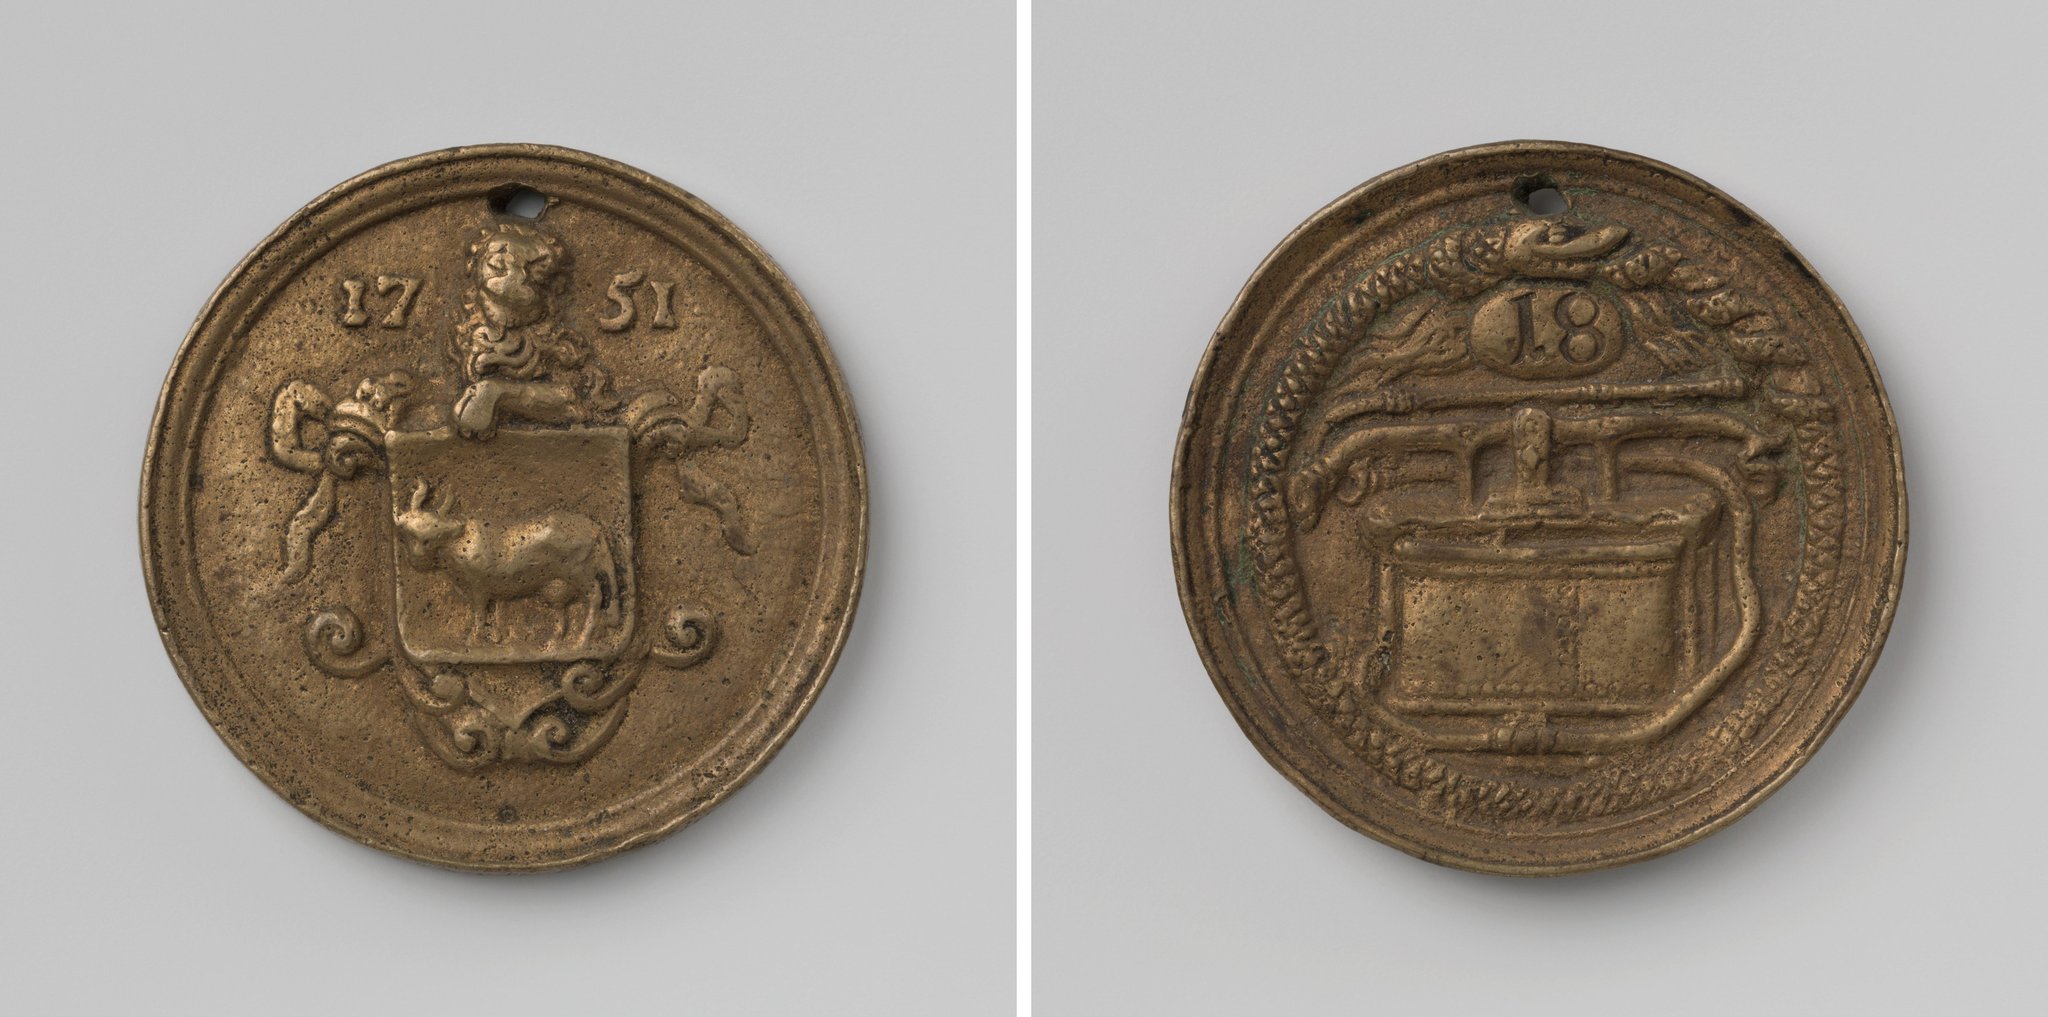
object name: fire engine medal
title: Beemster, brandspuitpenning met no. 18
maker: Anonymous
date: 1751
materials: brass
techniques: casting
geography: beemster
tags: beemster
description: Messing penning met gat erin. Voorzijde: wapenschild, gedragen door leeuw tussen jaartal. Keerzijde: brandspuit onder cartouche met cijfer 18 binnen slangerond